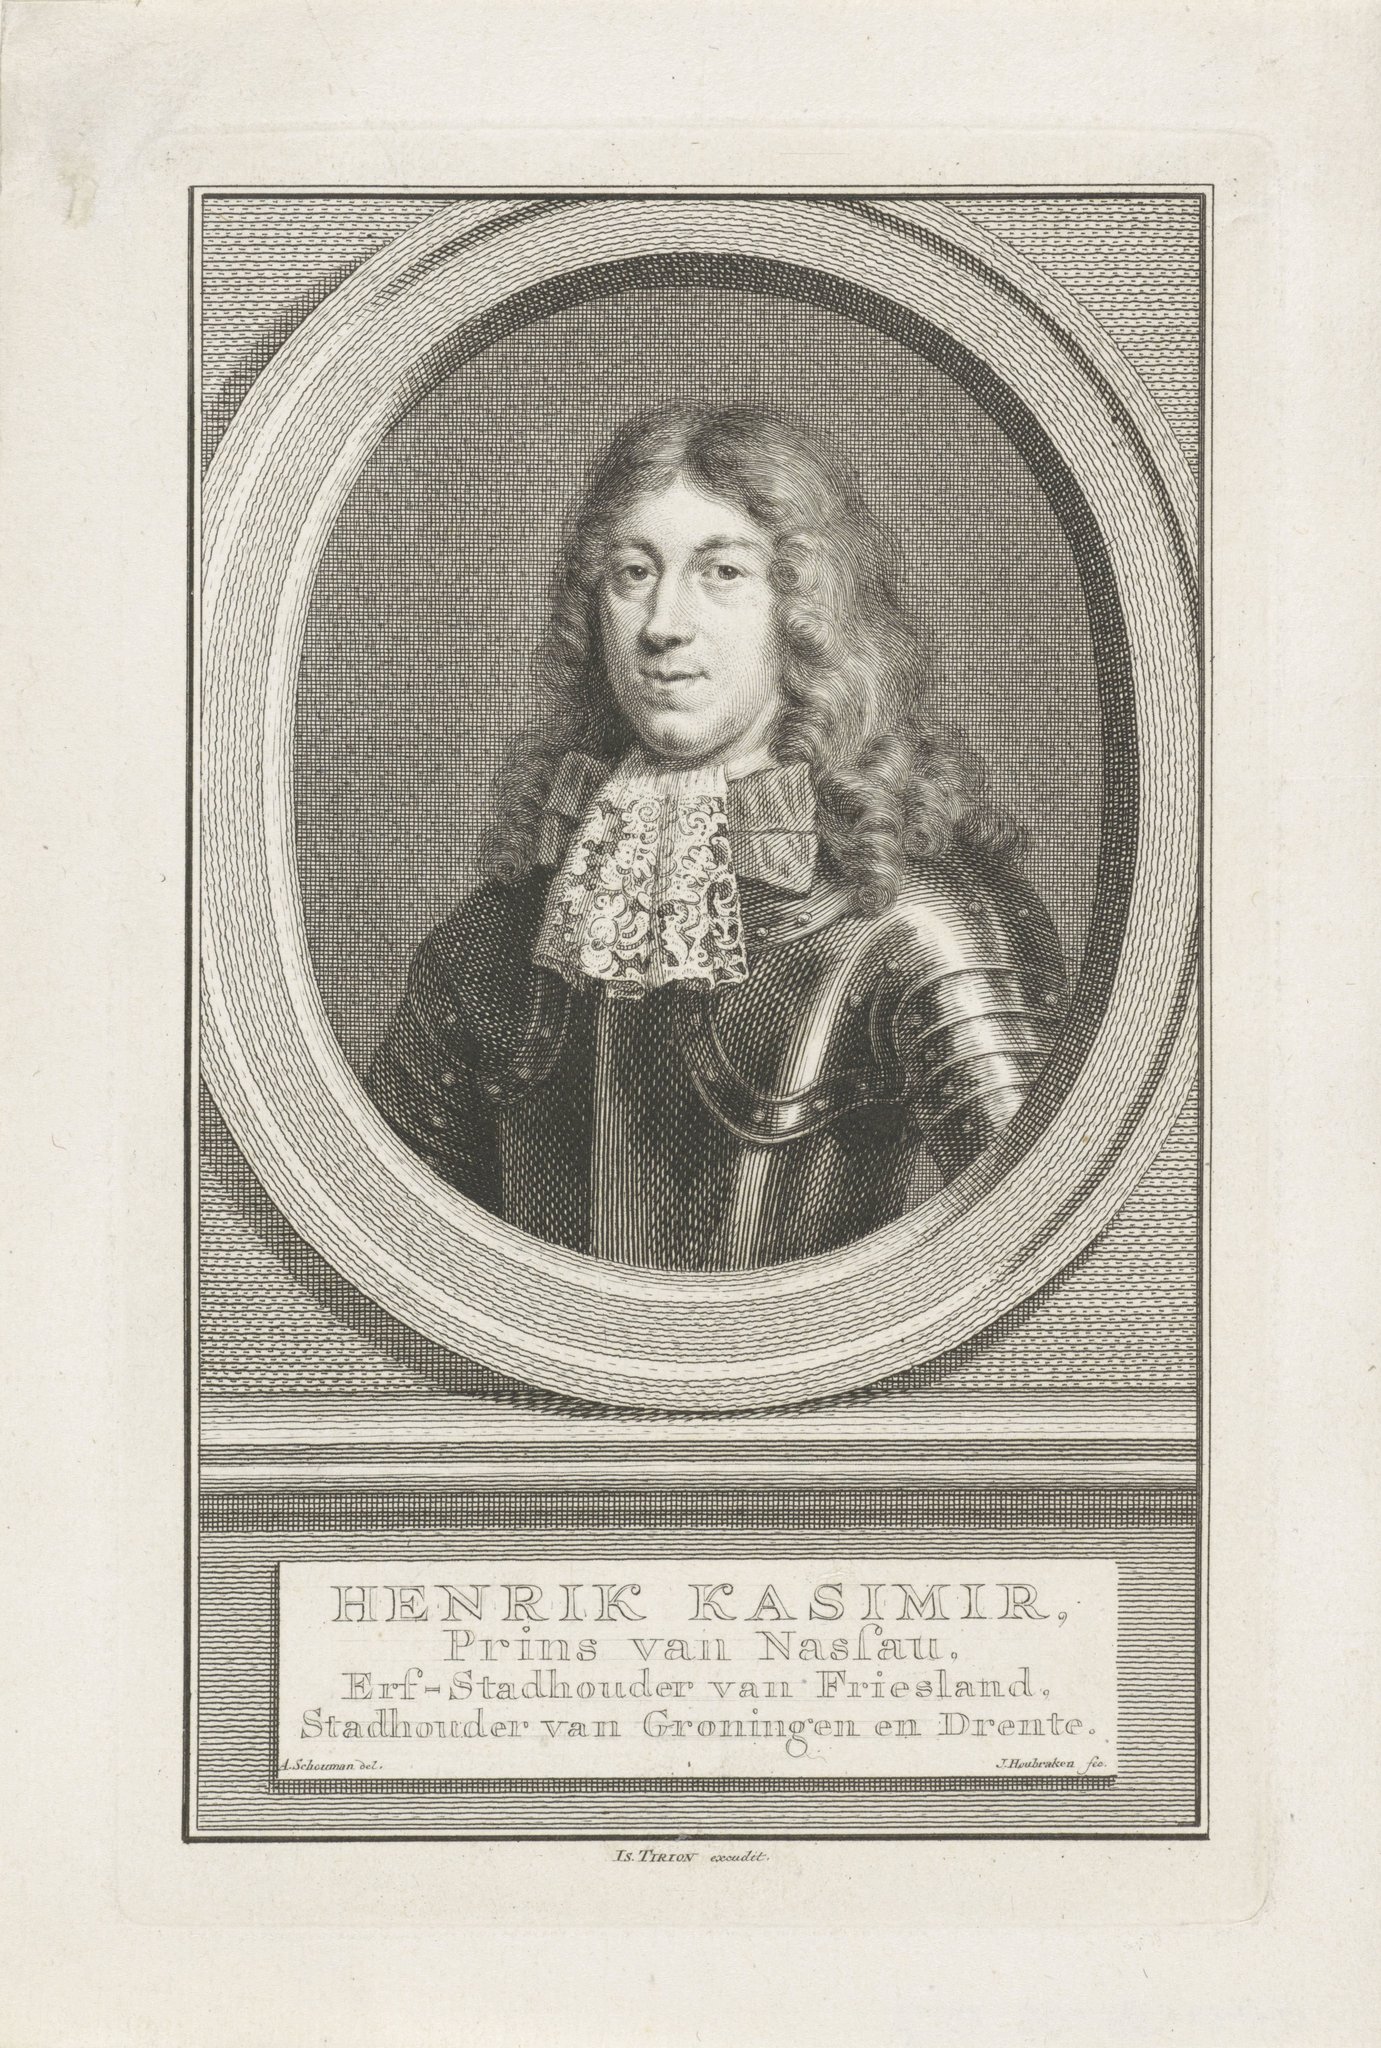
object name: book illustration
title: Portret van Hendrik Casimir II, graaf van Nassau-Dietz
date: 1749-1759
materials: paper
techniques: engraving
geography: amsterdam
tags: the hague, hendrik casimir ii graaf van nassau-dietz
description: De hier vermelde titel verwijst naar de hoogst verkregen titel van de geportretteerde, niet per se naar de titel die de geportretteerde op deze voorstelling draagt. Prent uit: Wagenaar, Jan. Vaderlandsche historie. Amsterdam: Isaak Tirion, 1749-1759.